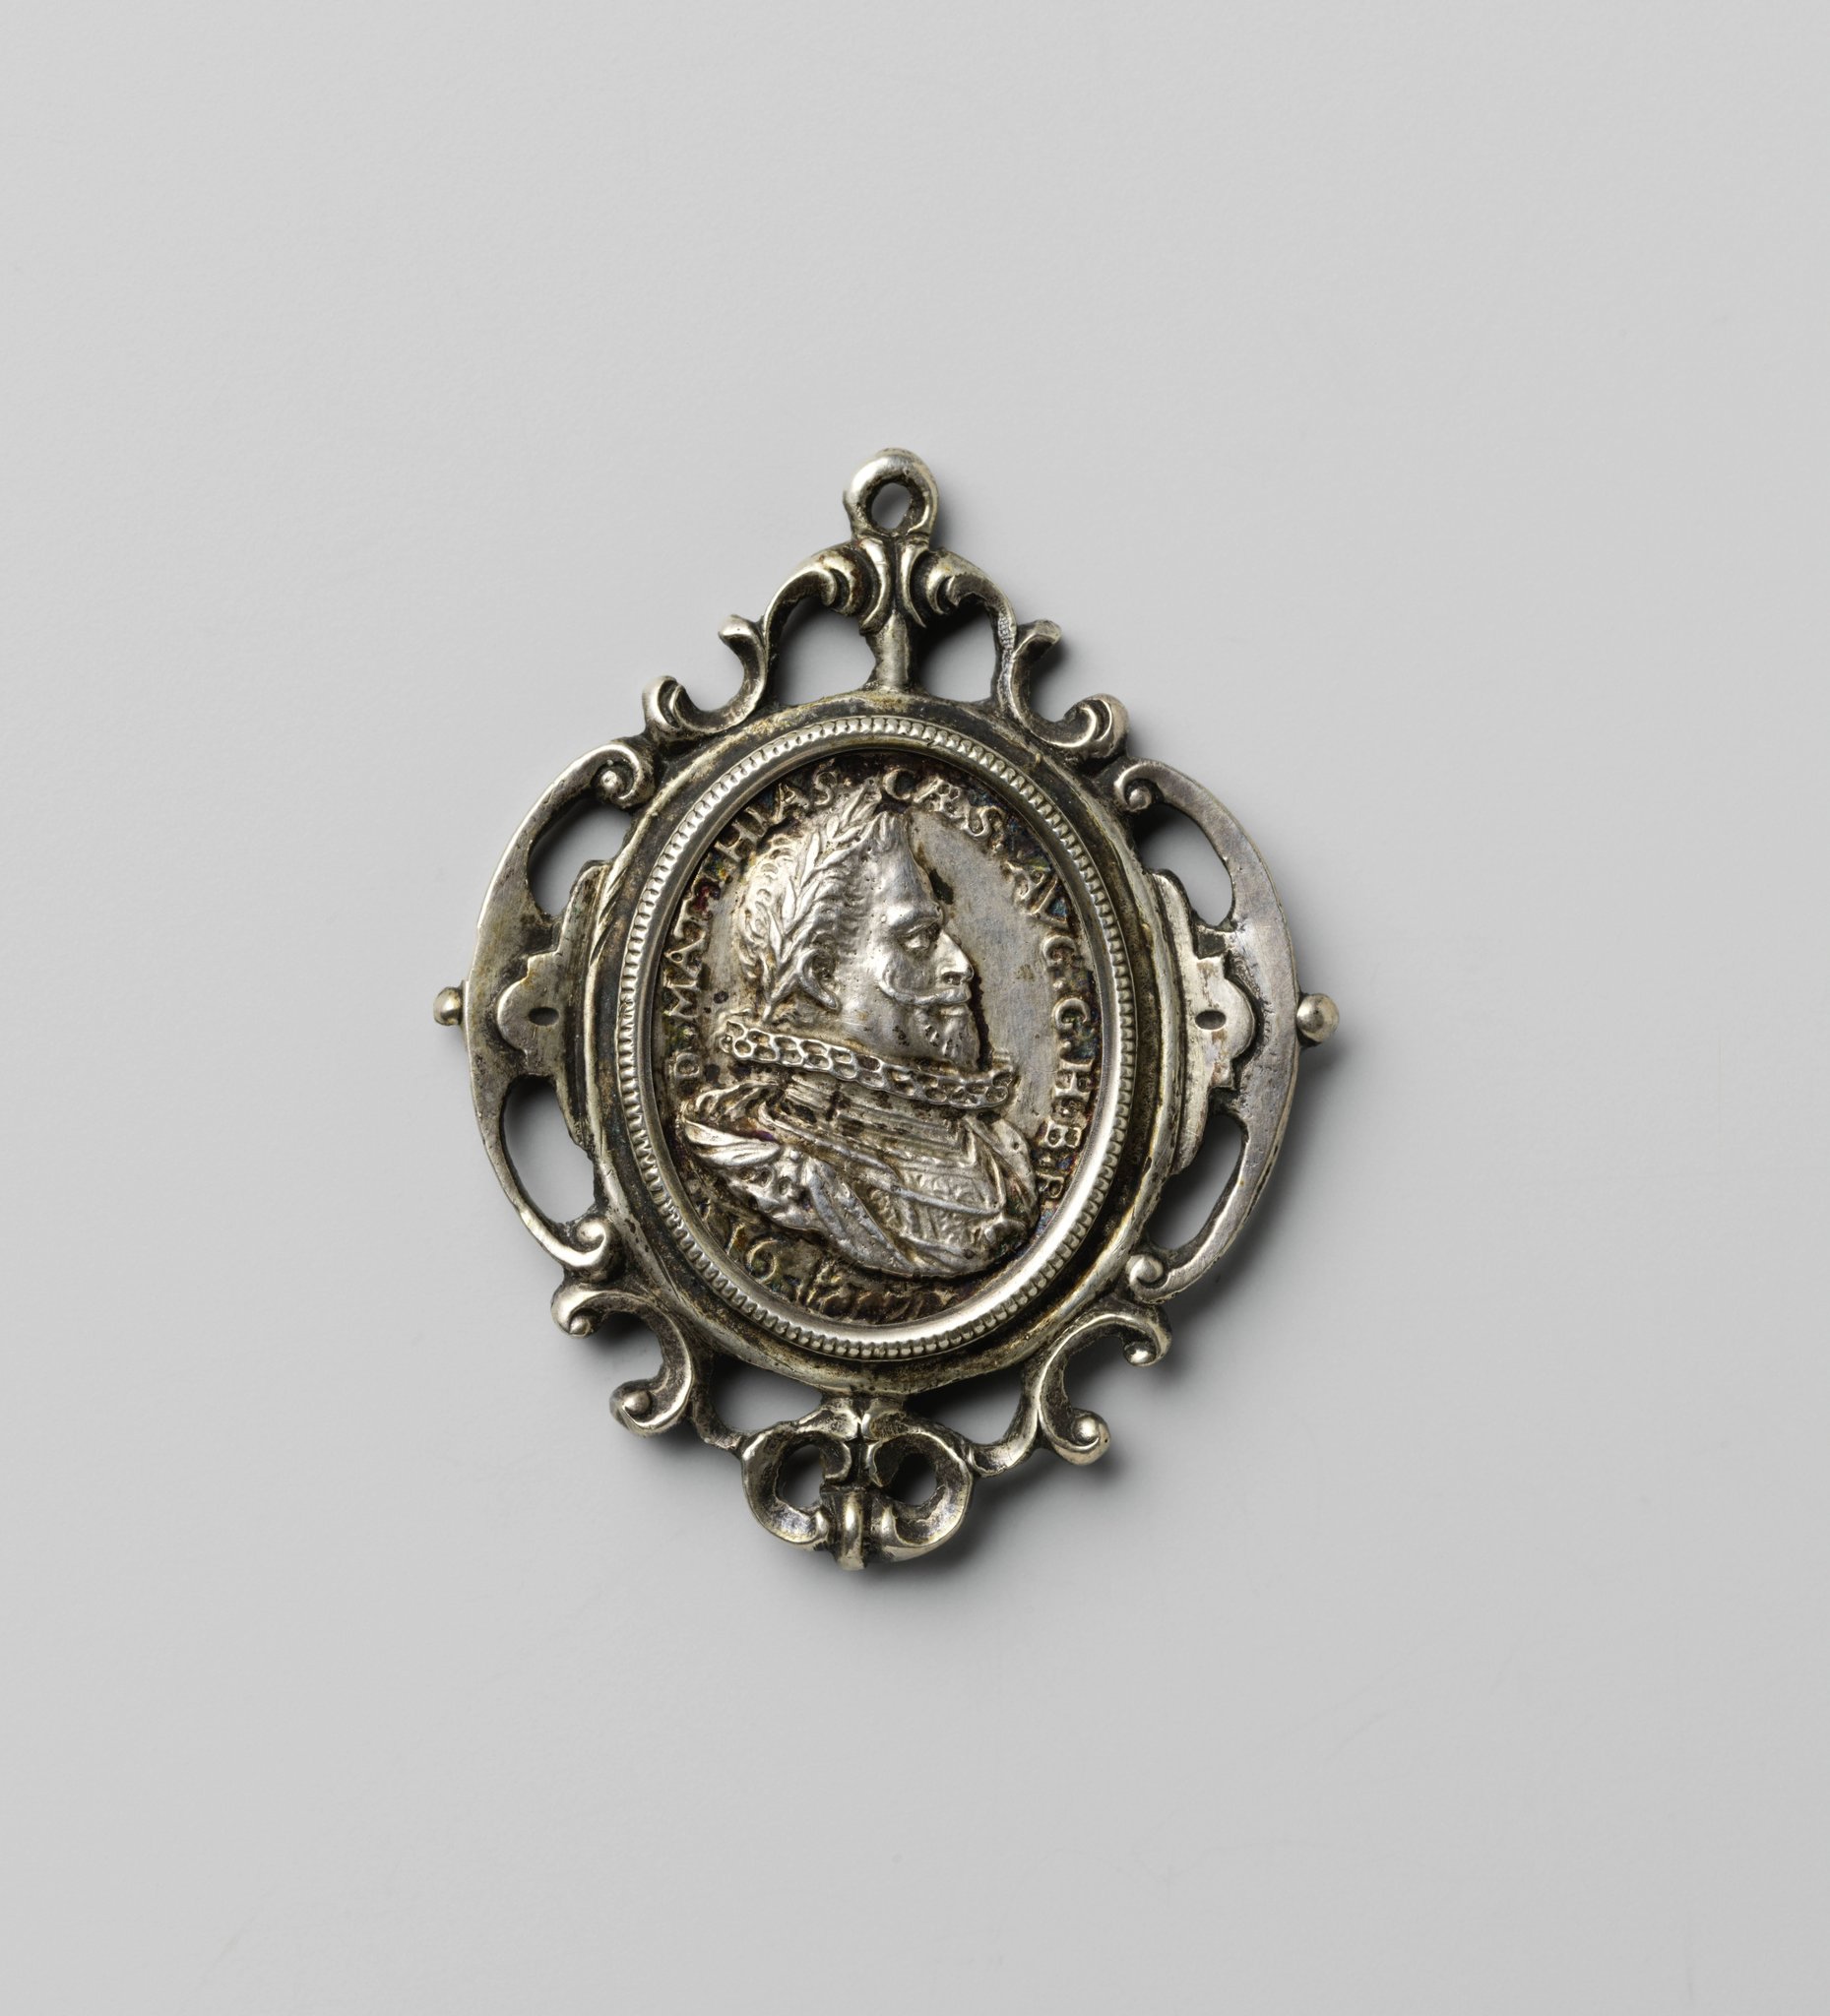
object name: pendant jewelry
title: Hanger in de vorm van een ovale penning met portret van keizer Matthias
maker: jan de vos (ca. 1578-?)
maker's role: silversmith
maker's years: 1578-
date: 1614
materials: silver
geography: southern germany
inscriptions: date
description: Hanger van zilver, gevormd uit een gemonteerde ovale penning met het portret van keizer Matthias van Oostenrijk.